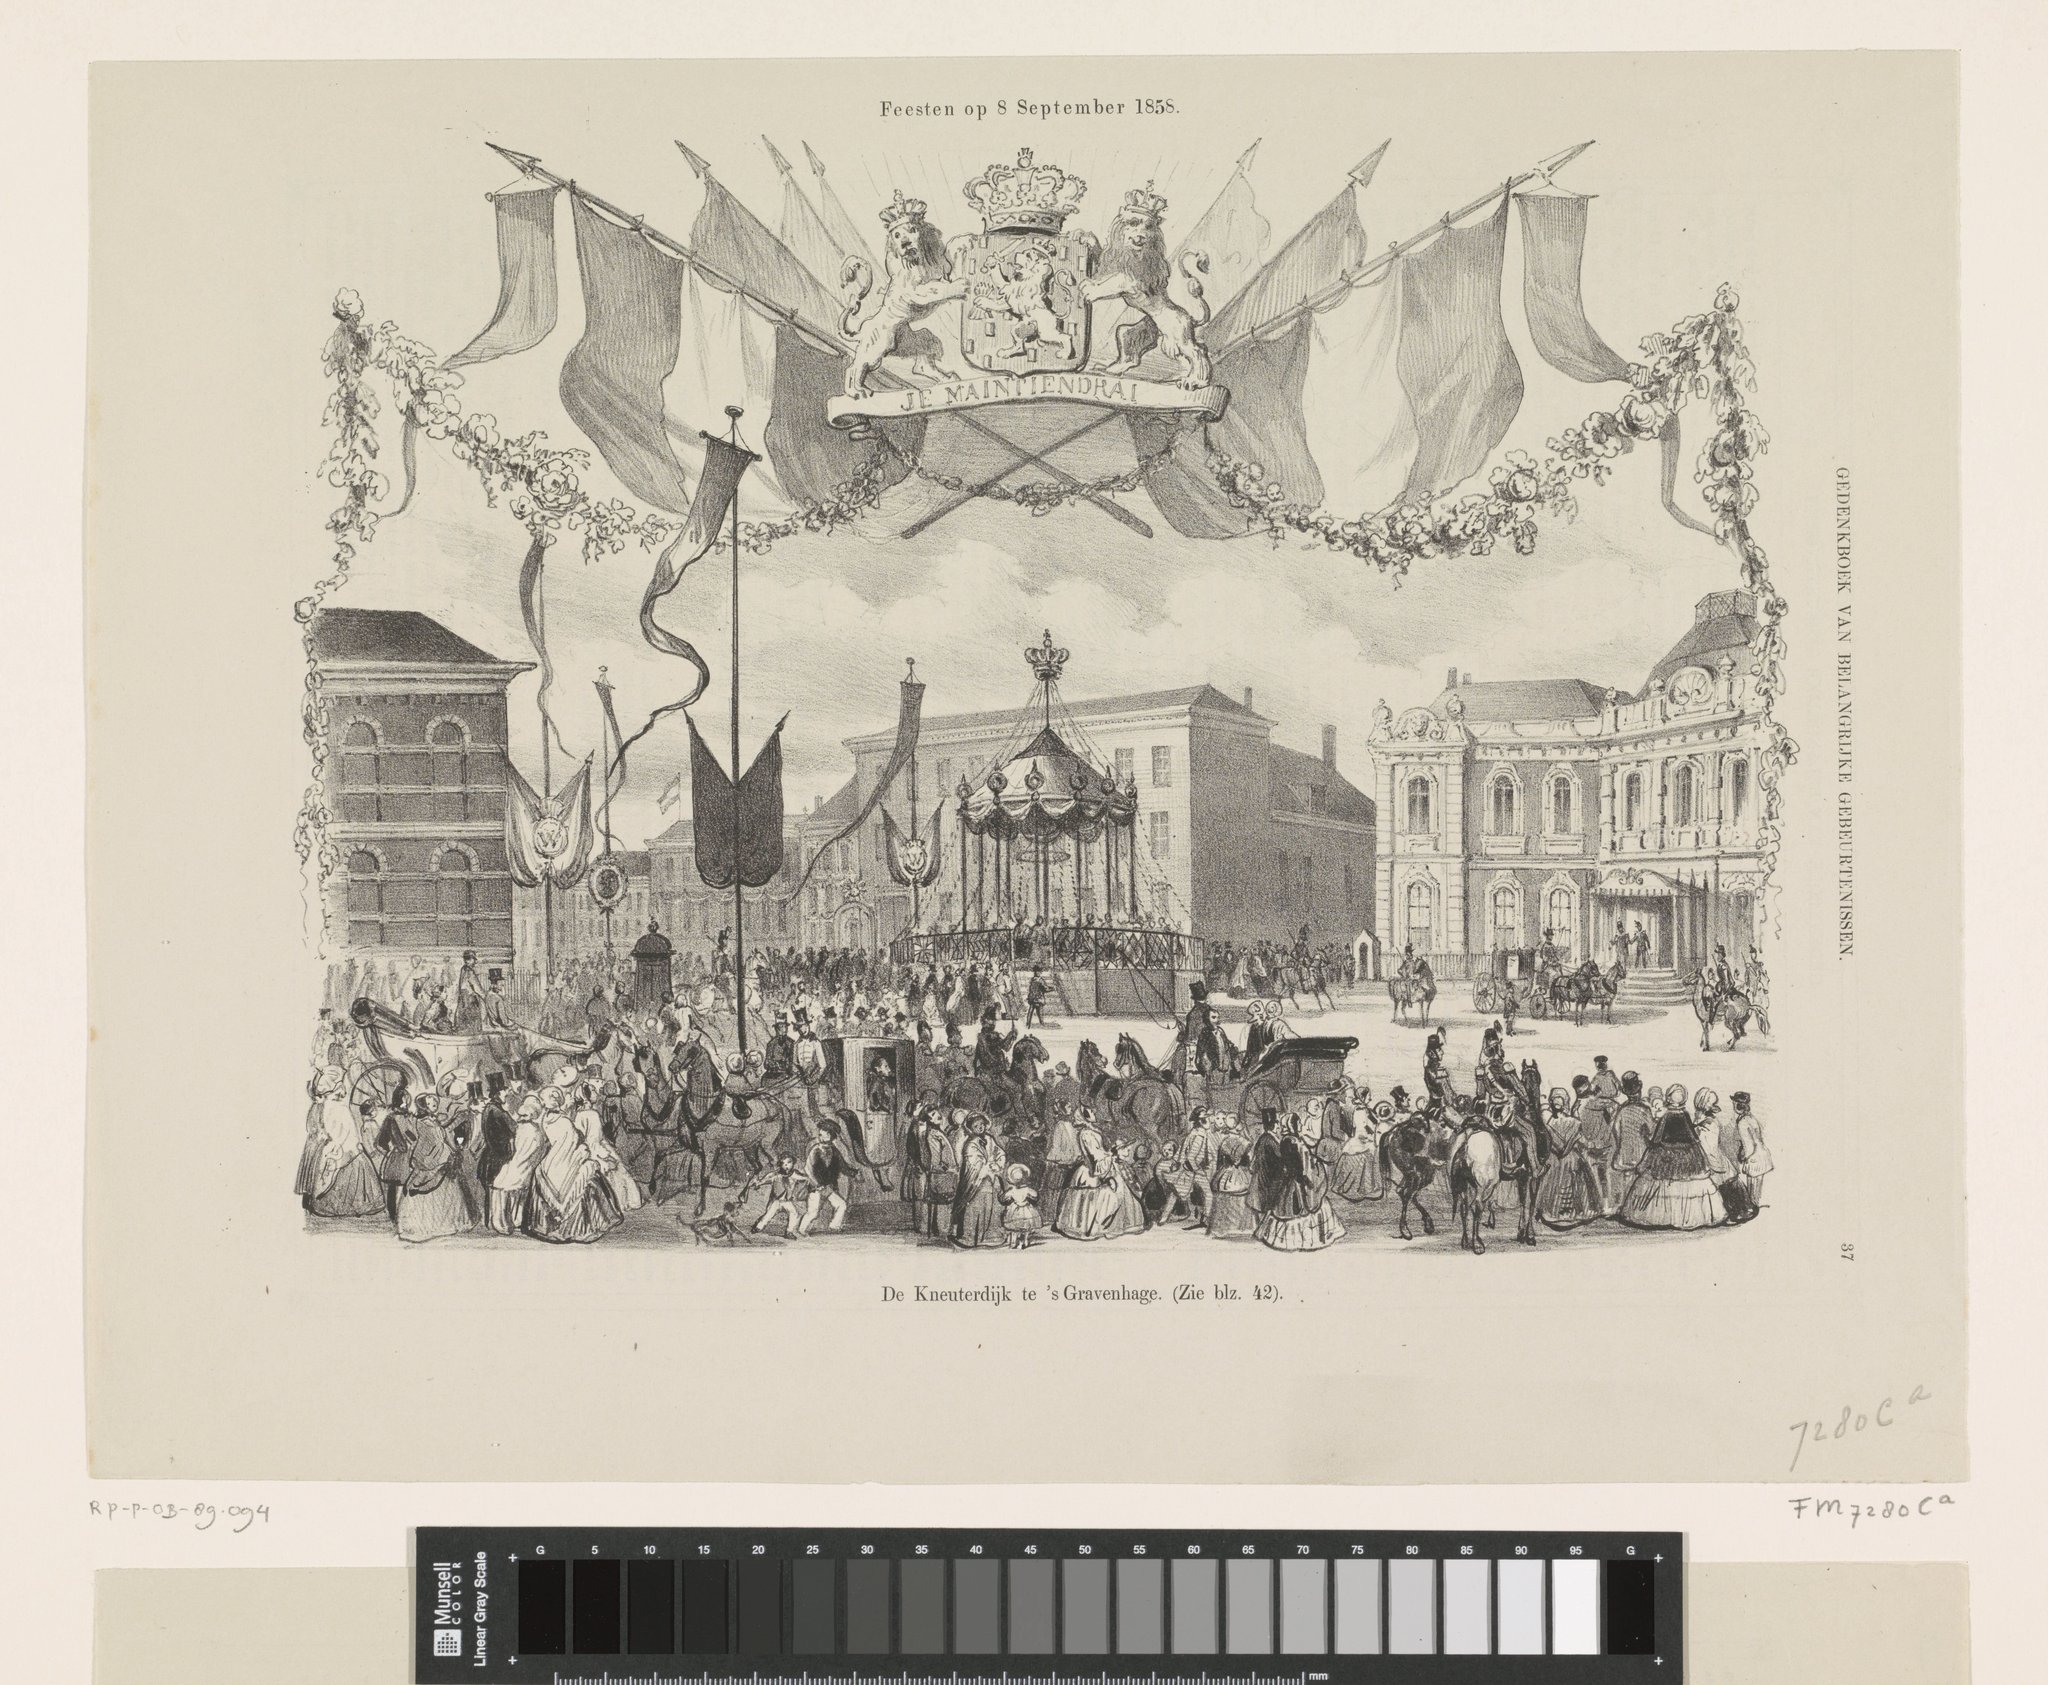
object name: book illustration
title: Feesten op 8 September 1858 / De Kneuterdijk te 's Gravenhage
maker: Anonymous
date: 1858-1859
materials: paper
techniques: lithograph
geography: netherlands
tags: paris, willem (prins der nederlanden), public festivities at other royal events, not meant or mentioned above, the hague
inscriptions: collector's mark: Lugt 2228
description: Feestelijkheden voor Paleis Kneuterdijk te Den Haag op 8 september 1858, ter gelegenheid van het meerderjarig worden van Willem, prins van Oranje-Nassau op 4 september 1858. Bovenaan het rijkswapen tussen vaandels. Blad genummerd p. 37 en bedrukt met tekst op verso.